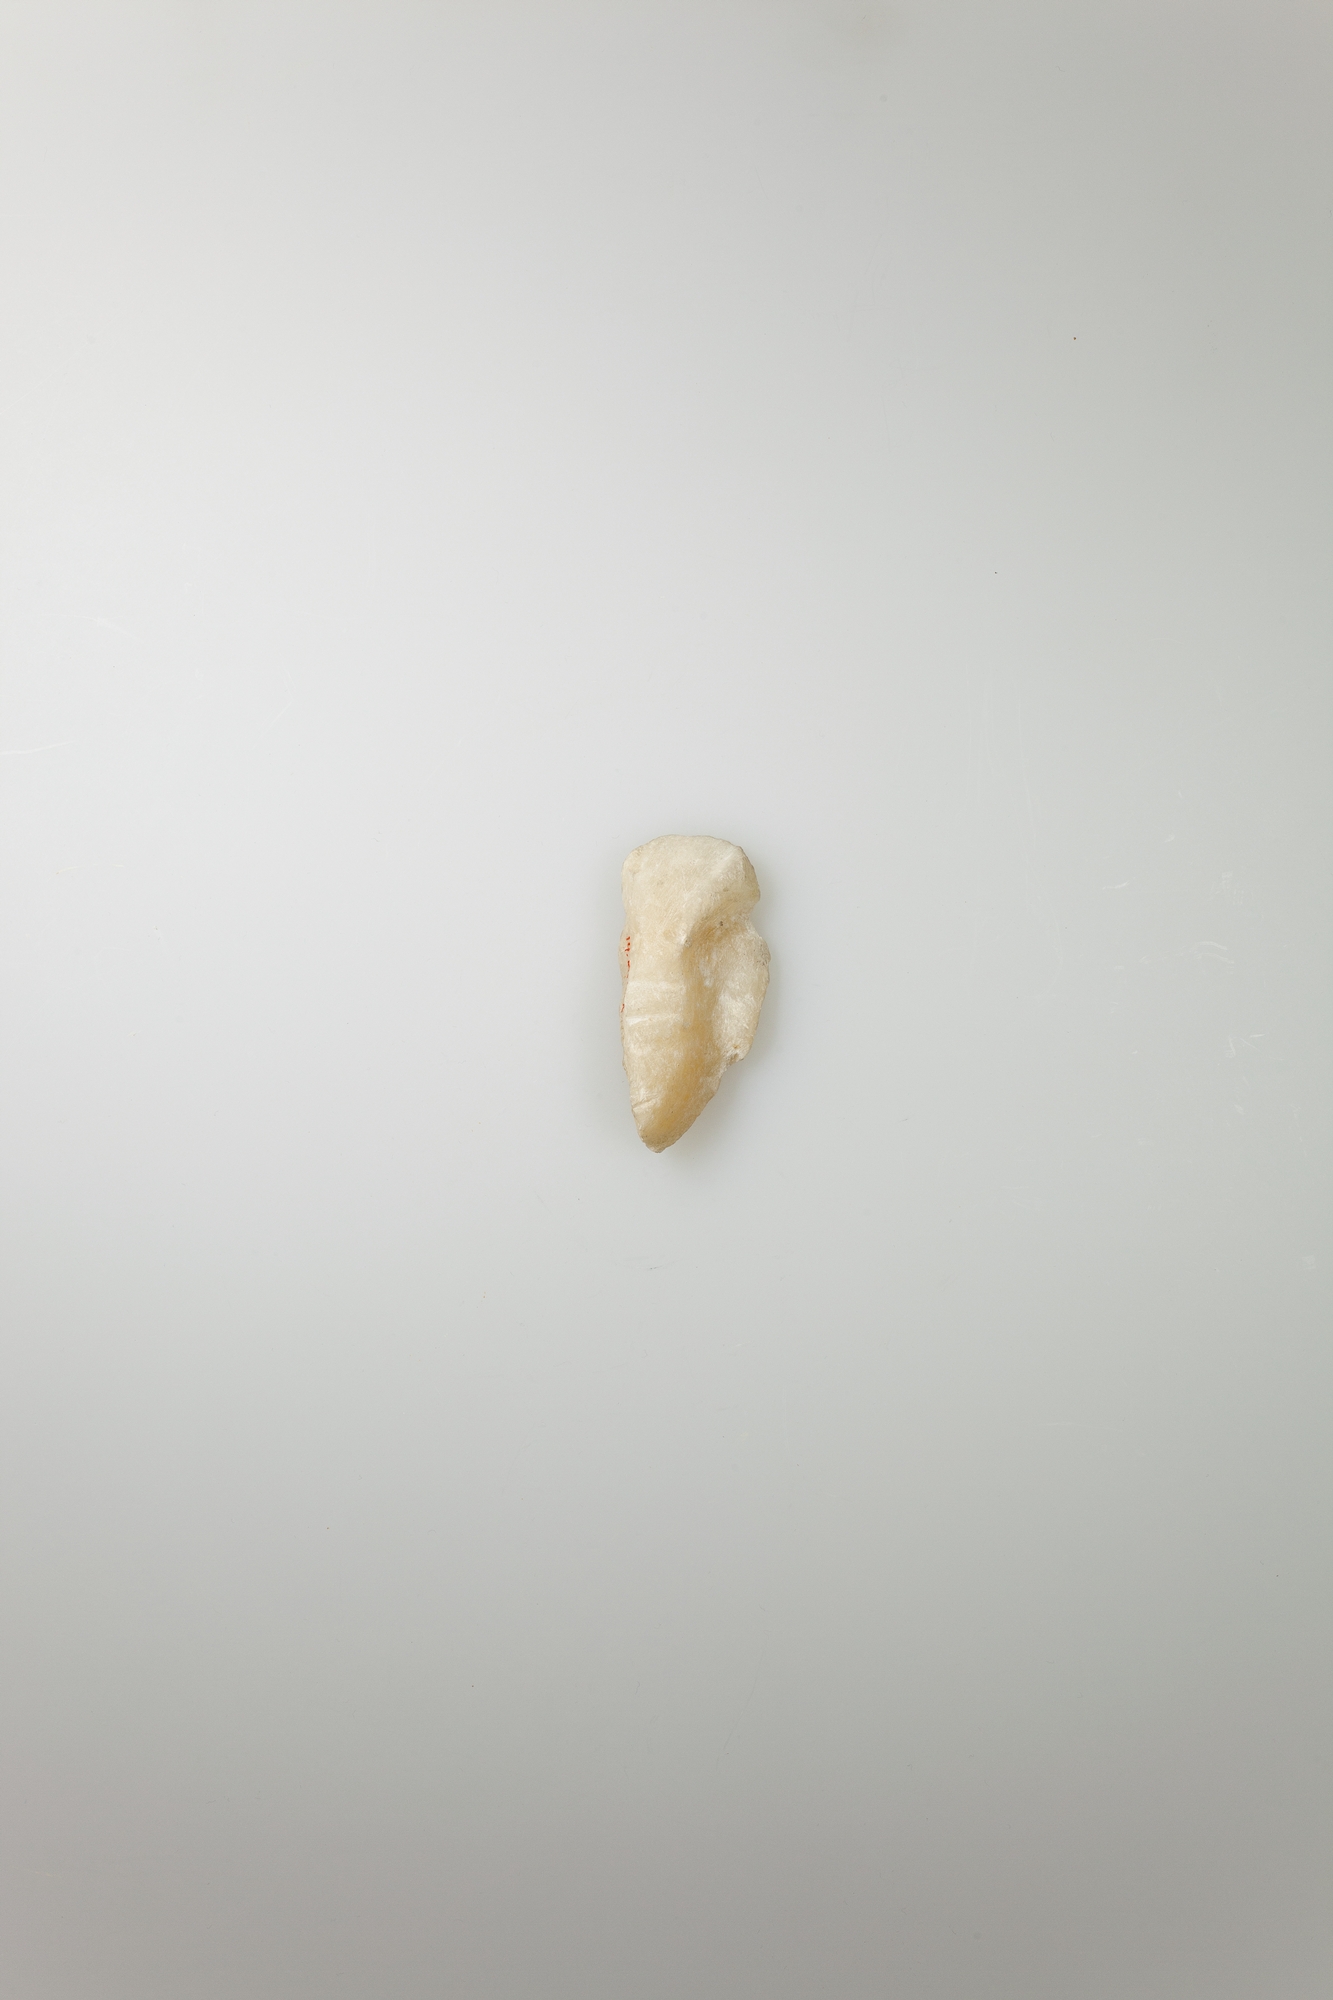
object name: shabti, siptah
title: Shabti of Siptah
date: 1194-1188 BCE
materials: stone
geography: egypt